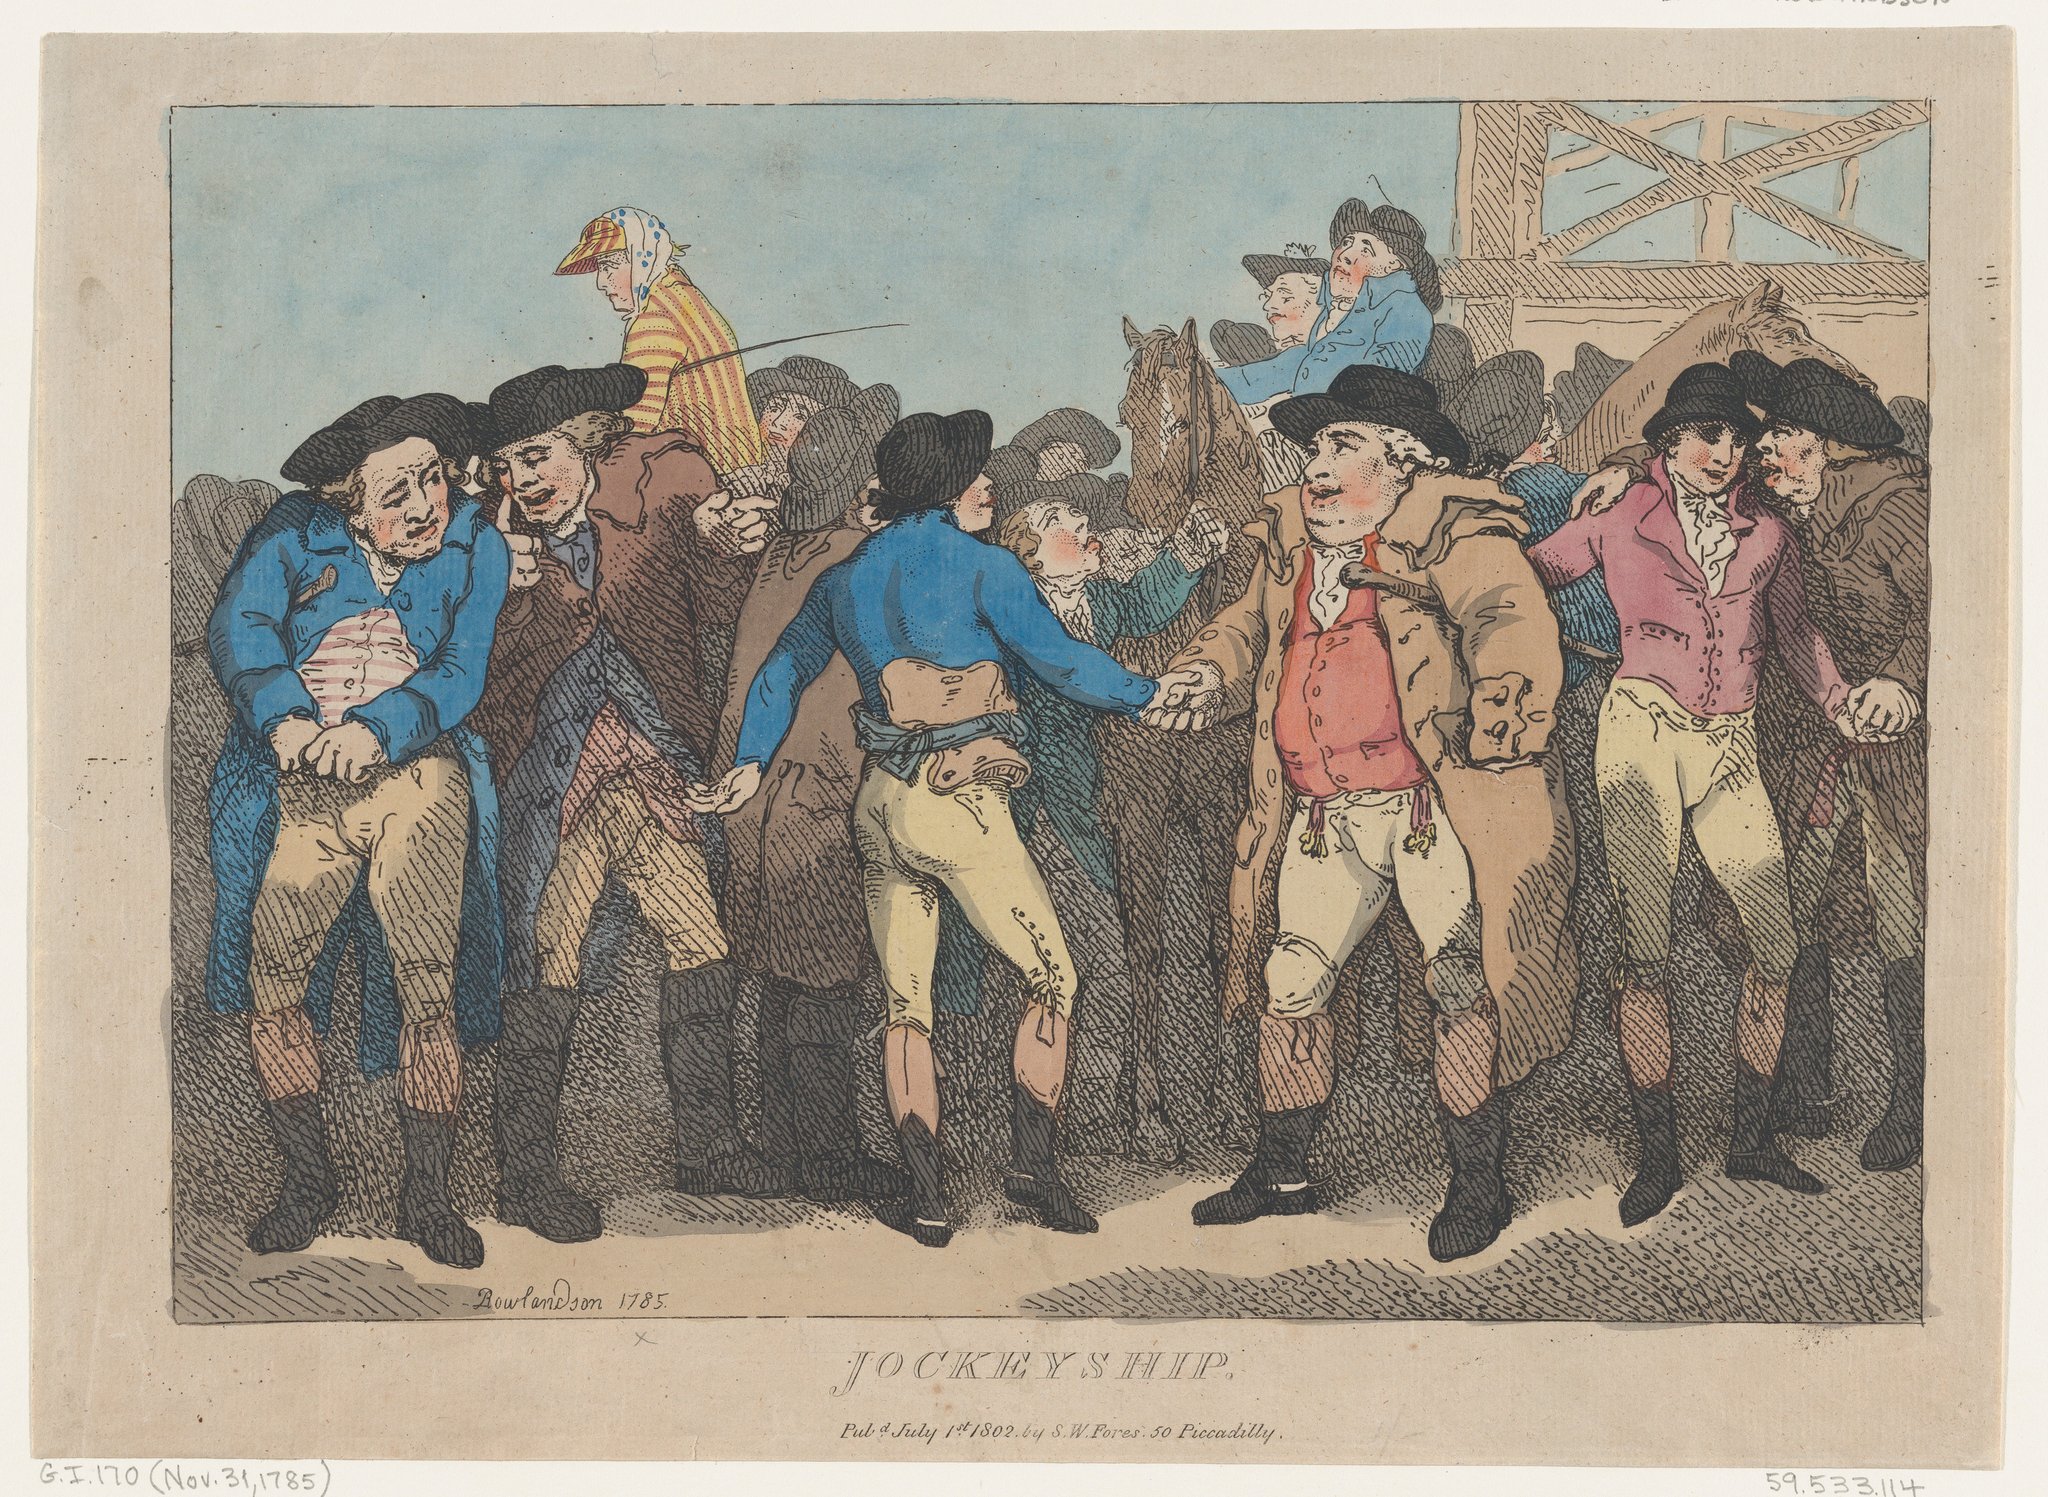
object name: print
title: Jockeyship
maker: thomas rowlandson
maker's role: artist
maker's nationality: british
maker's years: 1757-1827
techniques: etching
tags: men,horses,jockeys